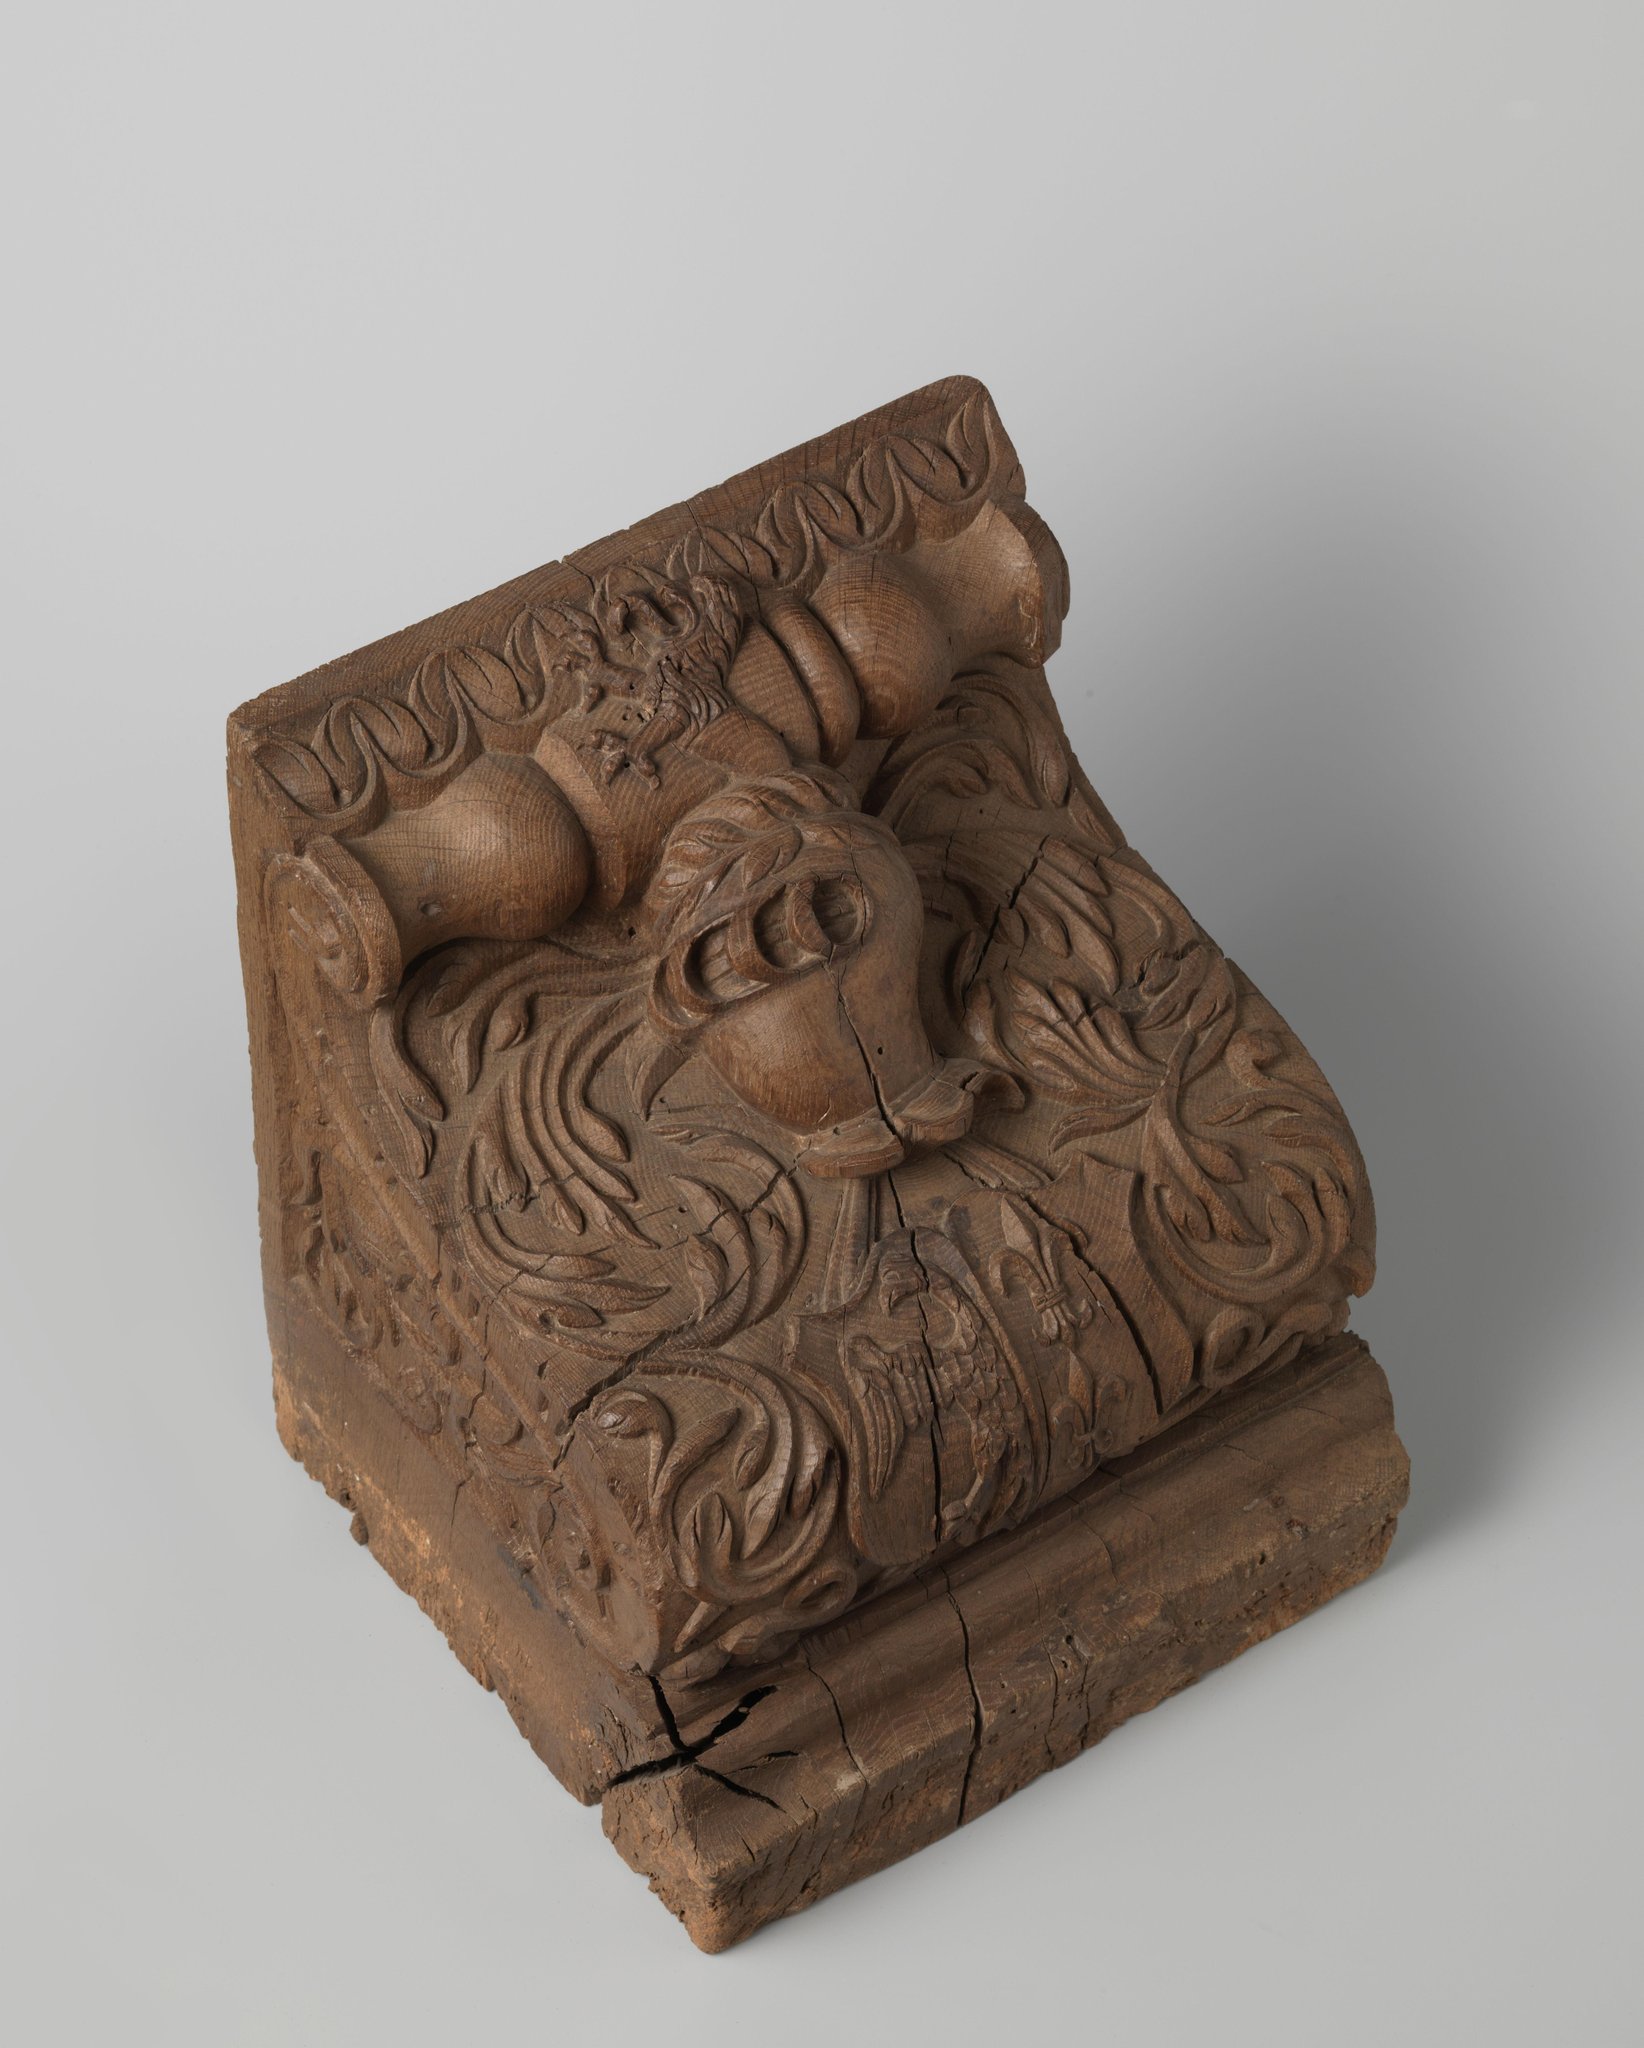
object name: korbeel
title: Korbeel met wapen Dekema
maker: Anonymous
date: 1600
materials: wood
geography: northern netherlands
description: Korbeel van eikenhout. Op het consolevormige voorstuk het wapen van de familie Dekema, waarboven een helm met als helmteken een leeuw. De zijkanten vertonen S-vormige voluten met in de uitgrondingen bloesems. Afkomstig uit de in 1887 gesloopte Stins te Franeker. (Zie ook inv.nr. BK-16706-a en BK-16706-c t/m -j)